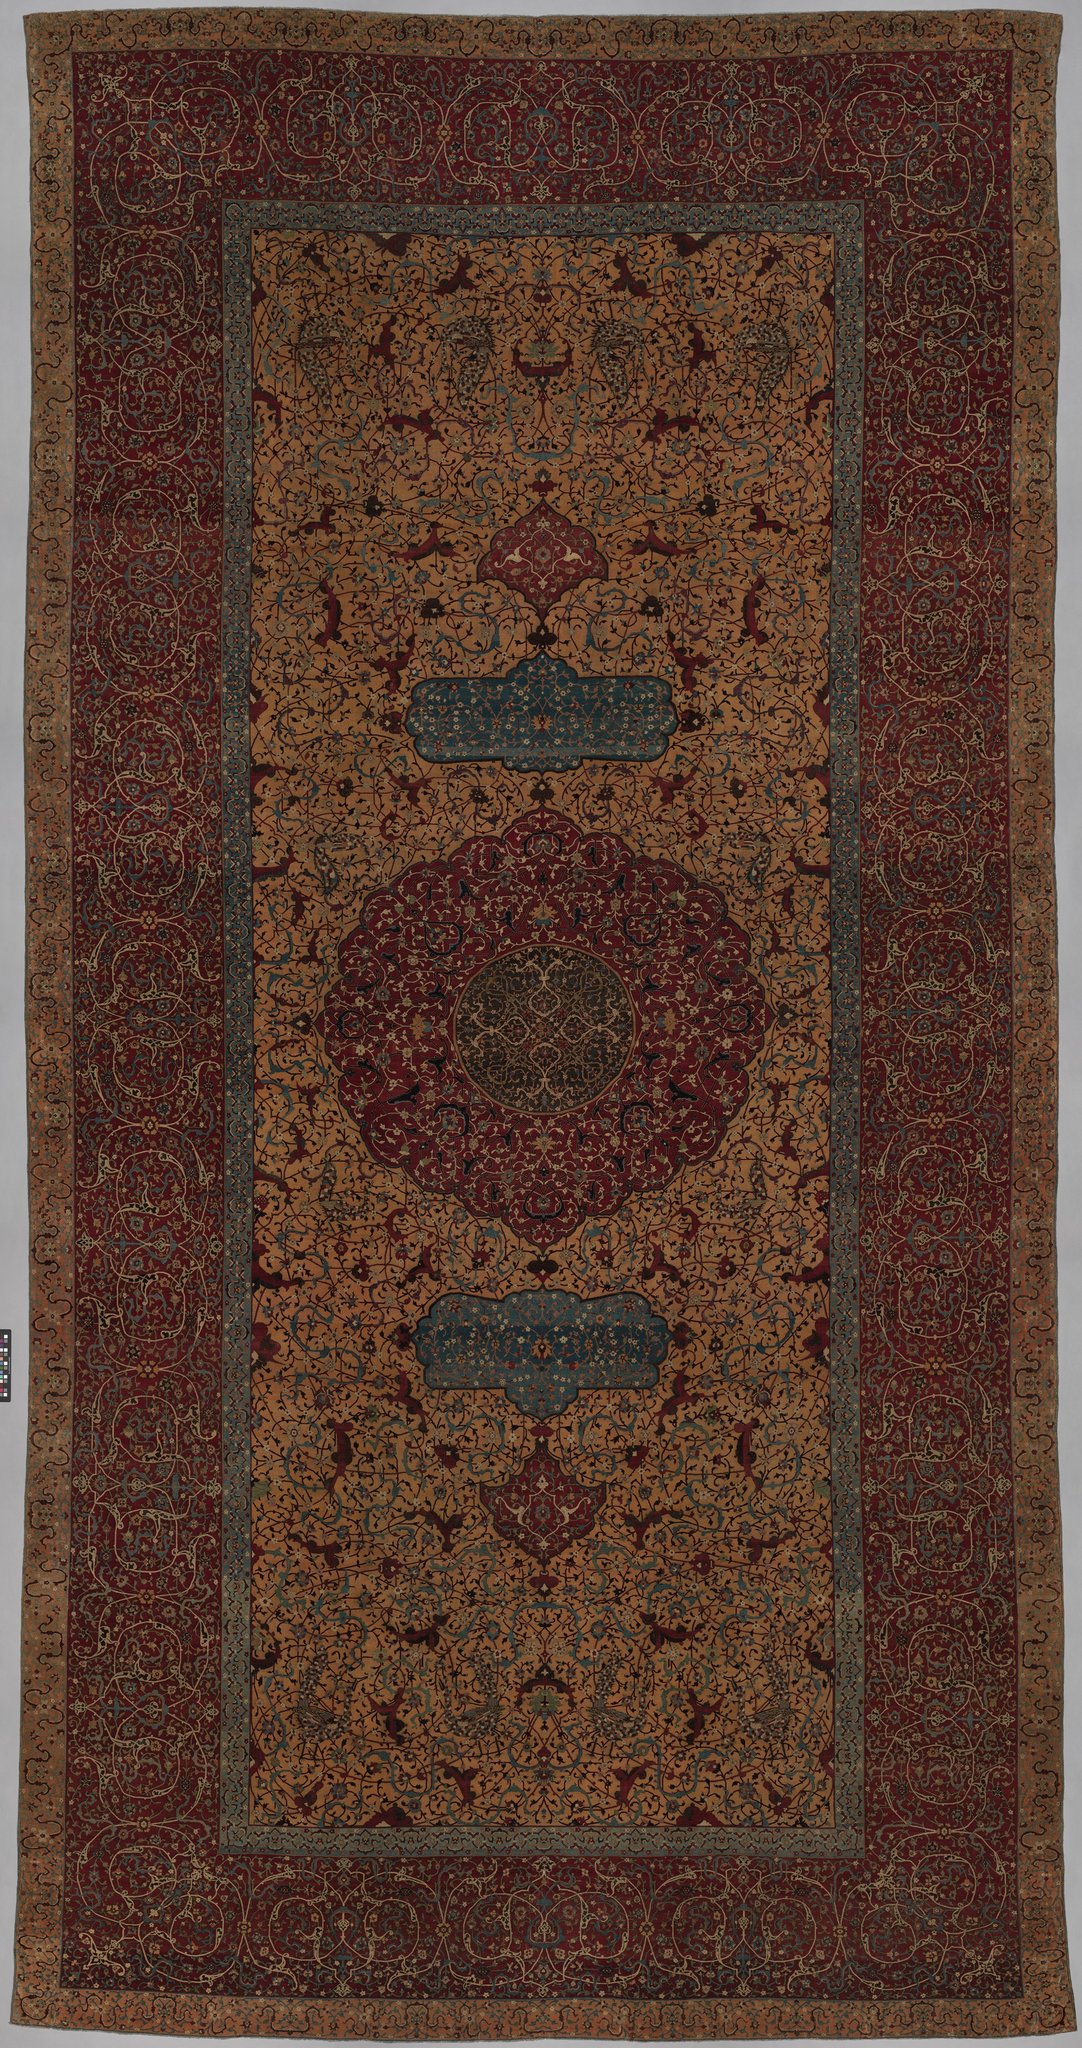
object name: carpet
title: The Anhalt Medallion Carpet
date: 1501-1550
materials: cotton, silk, wool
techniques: asymmetrically knotted pile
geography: iran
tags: peacocks,flowers,vines